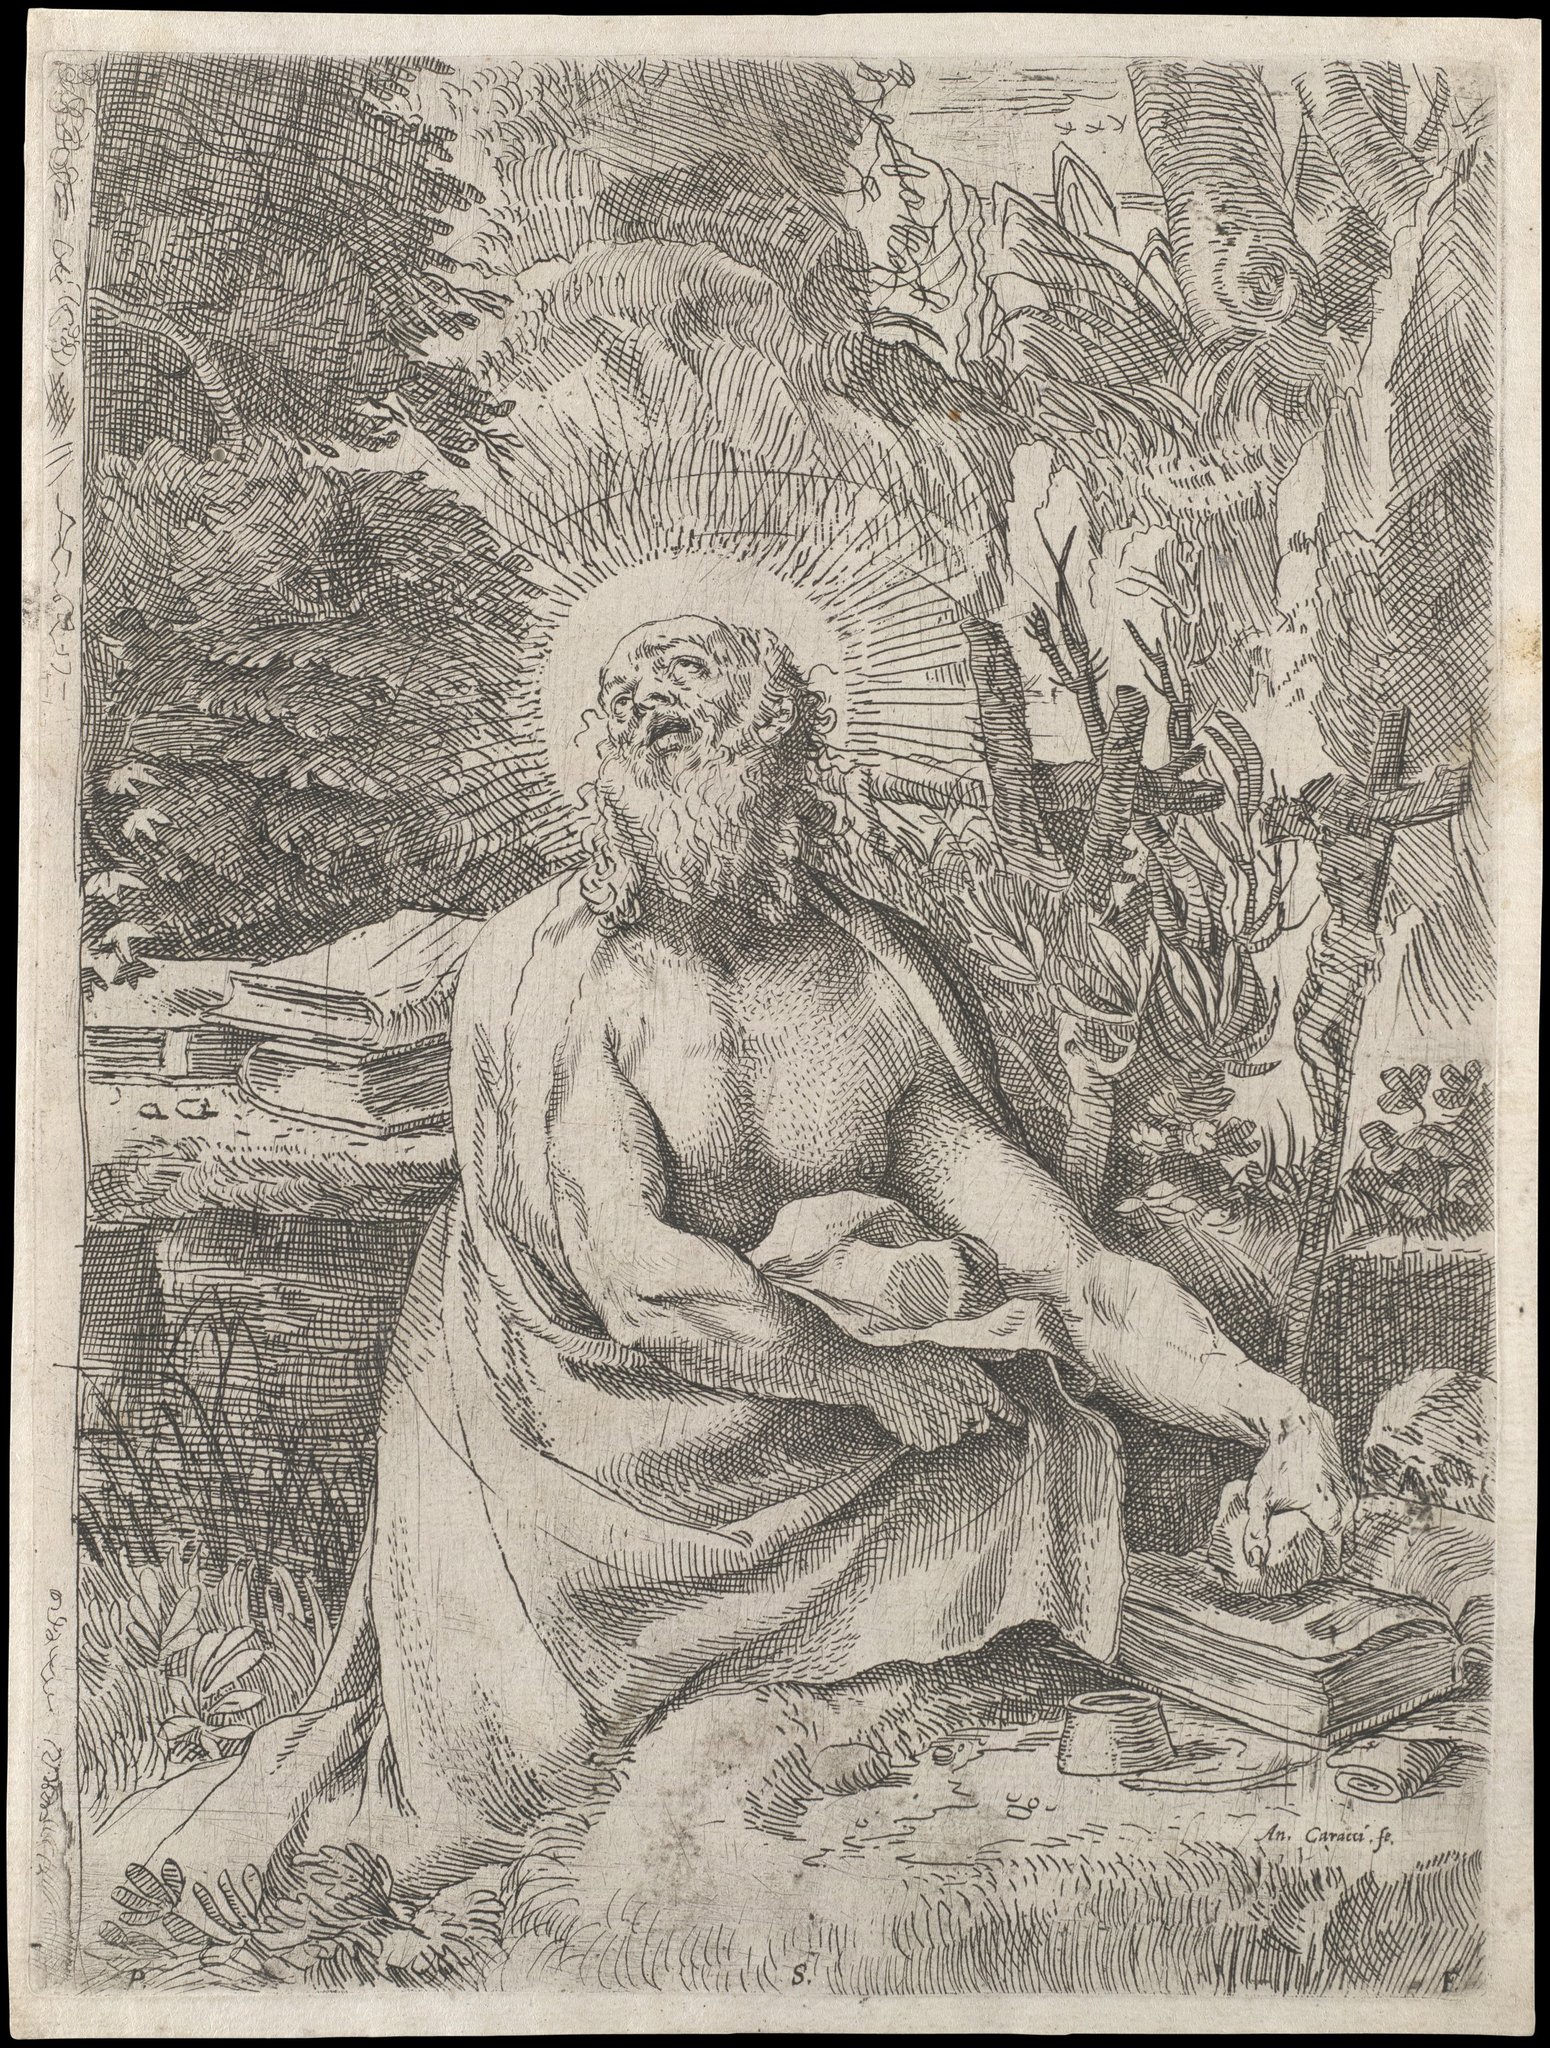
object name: print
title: Saint Jerome in the Wilderness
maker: annibale carracci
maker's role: artist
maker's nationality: italian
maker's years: 1560-1609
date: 1591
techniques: engraving, etching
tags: men,saint jerome